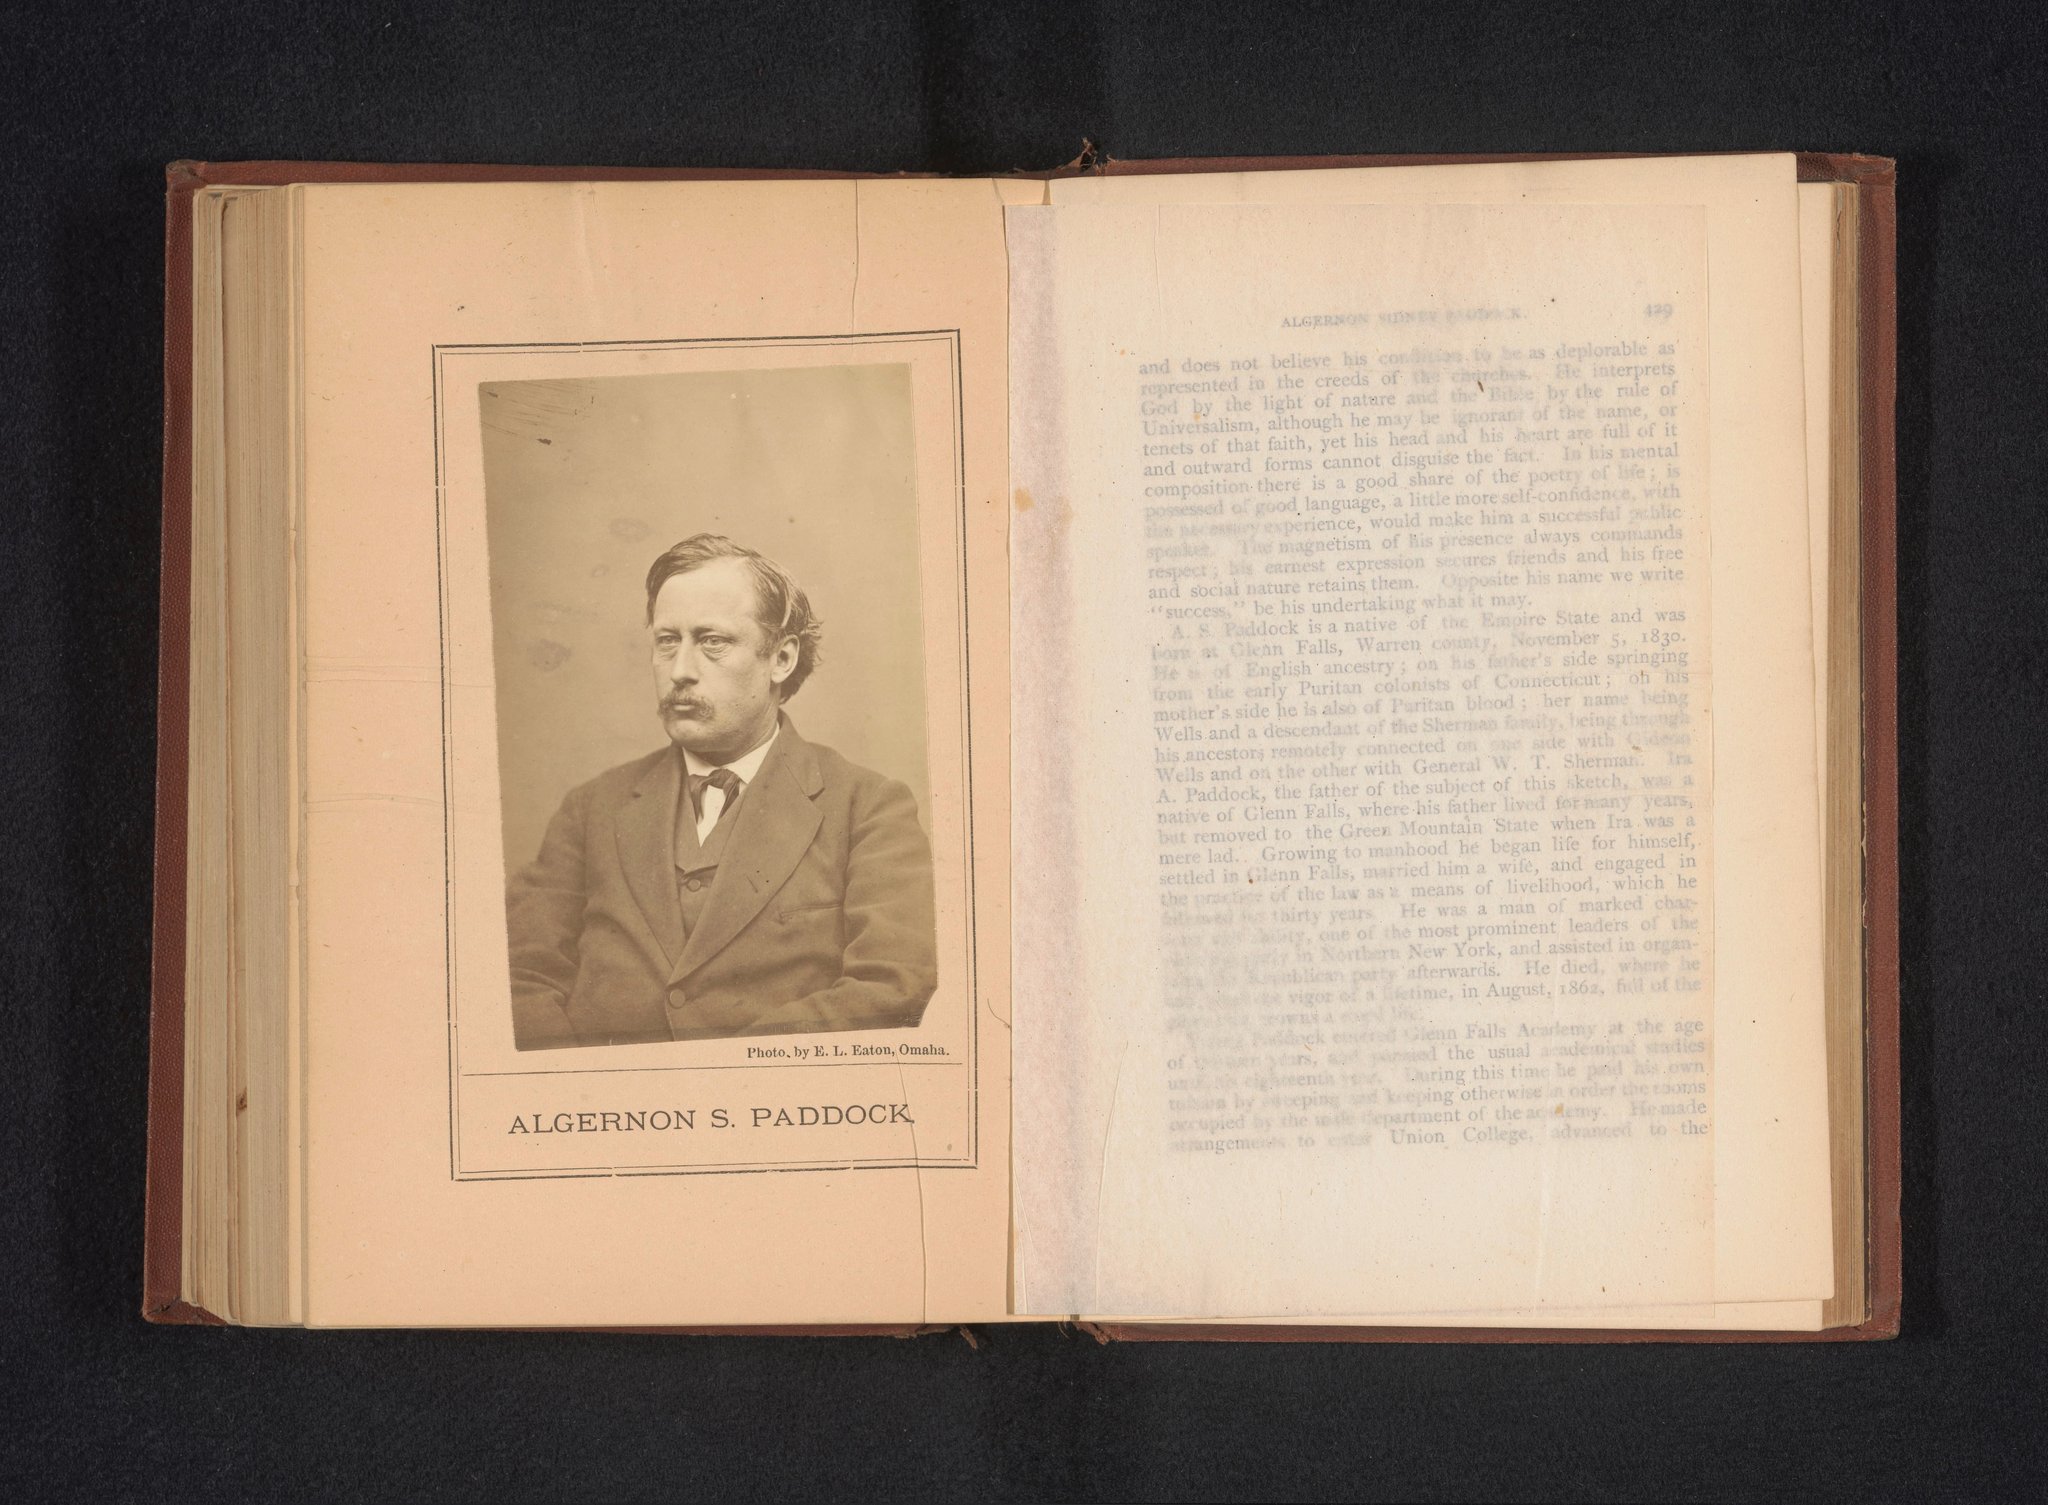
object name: photograph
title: Portret van Algernon Sidney Paddock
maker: edric l. eaton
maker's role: fotograaf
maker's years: 1835-1890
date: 1850-1862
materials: photographic support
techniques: albumen print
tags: new york, politician, historical persons, politician, e.g. party leader